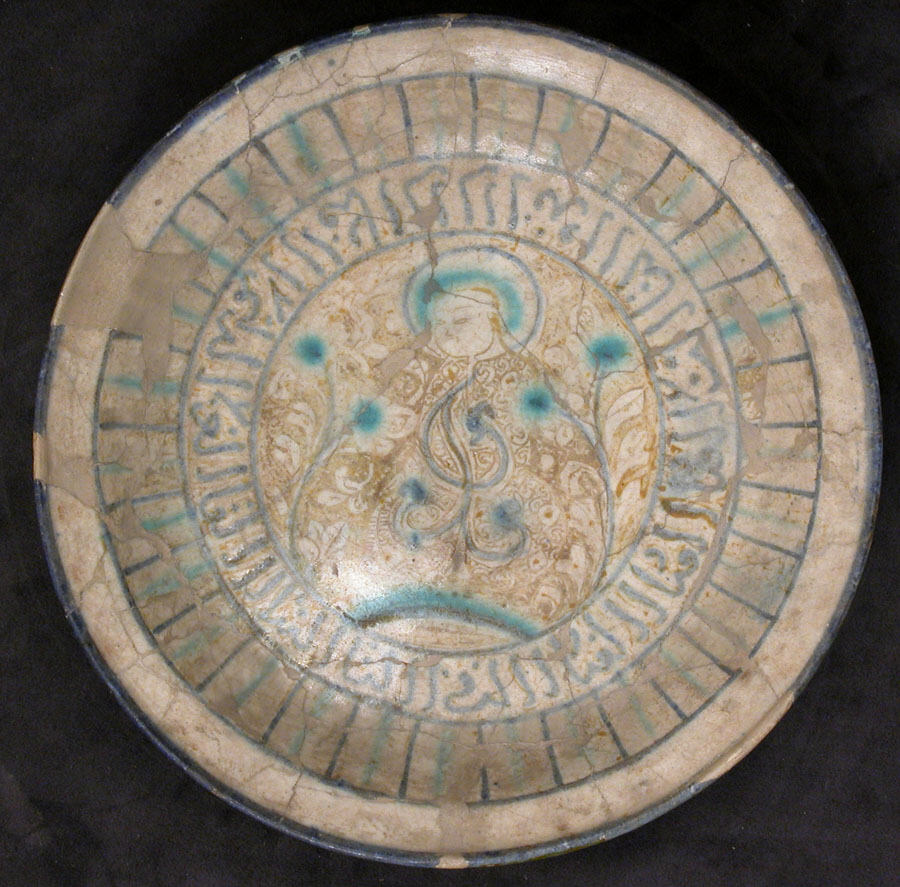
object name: dish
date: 1301-1400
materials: earthenware, glaze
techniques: painting, underglaze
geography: iran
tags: women